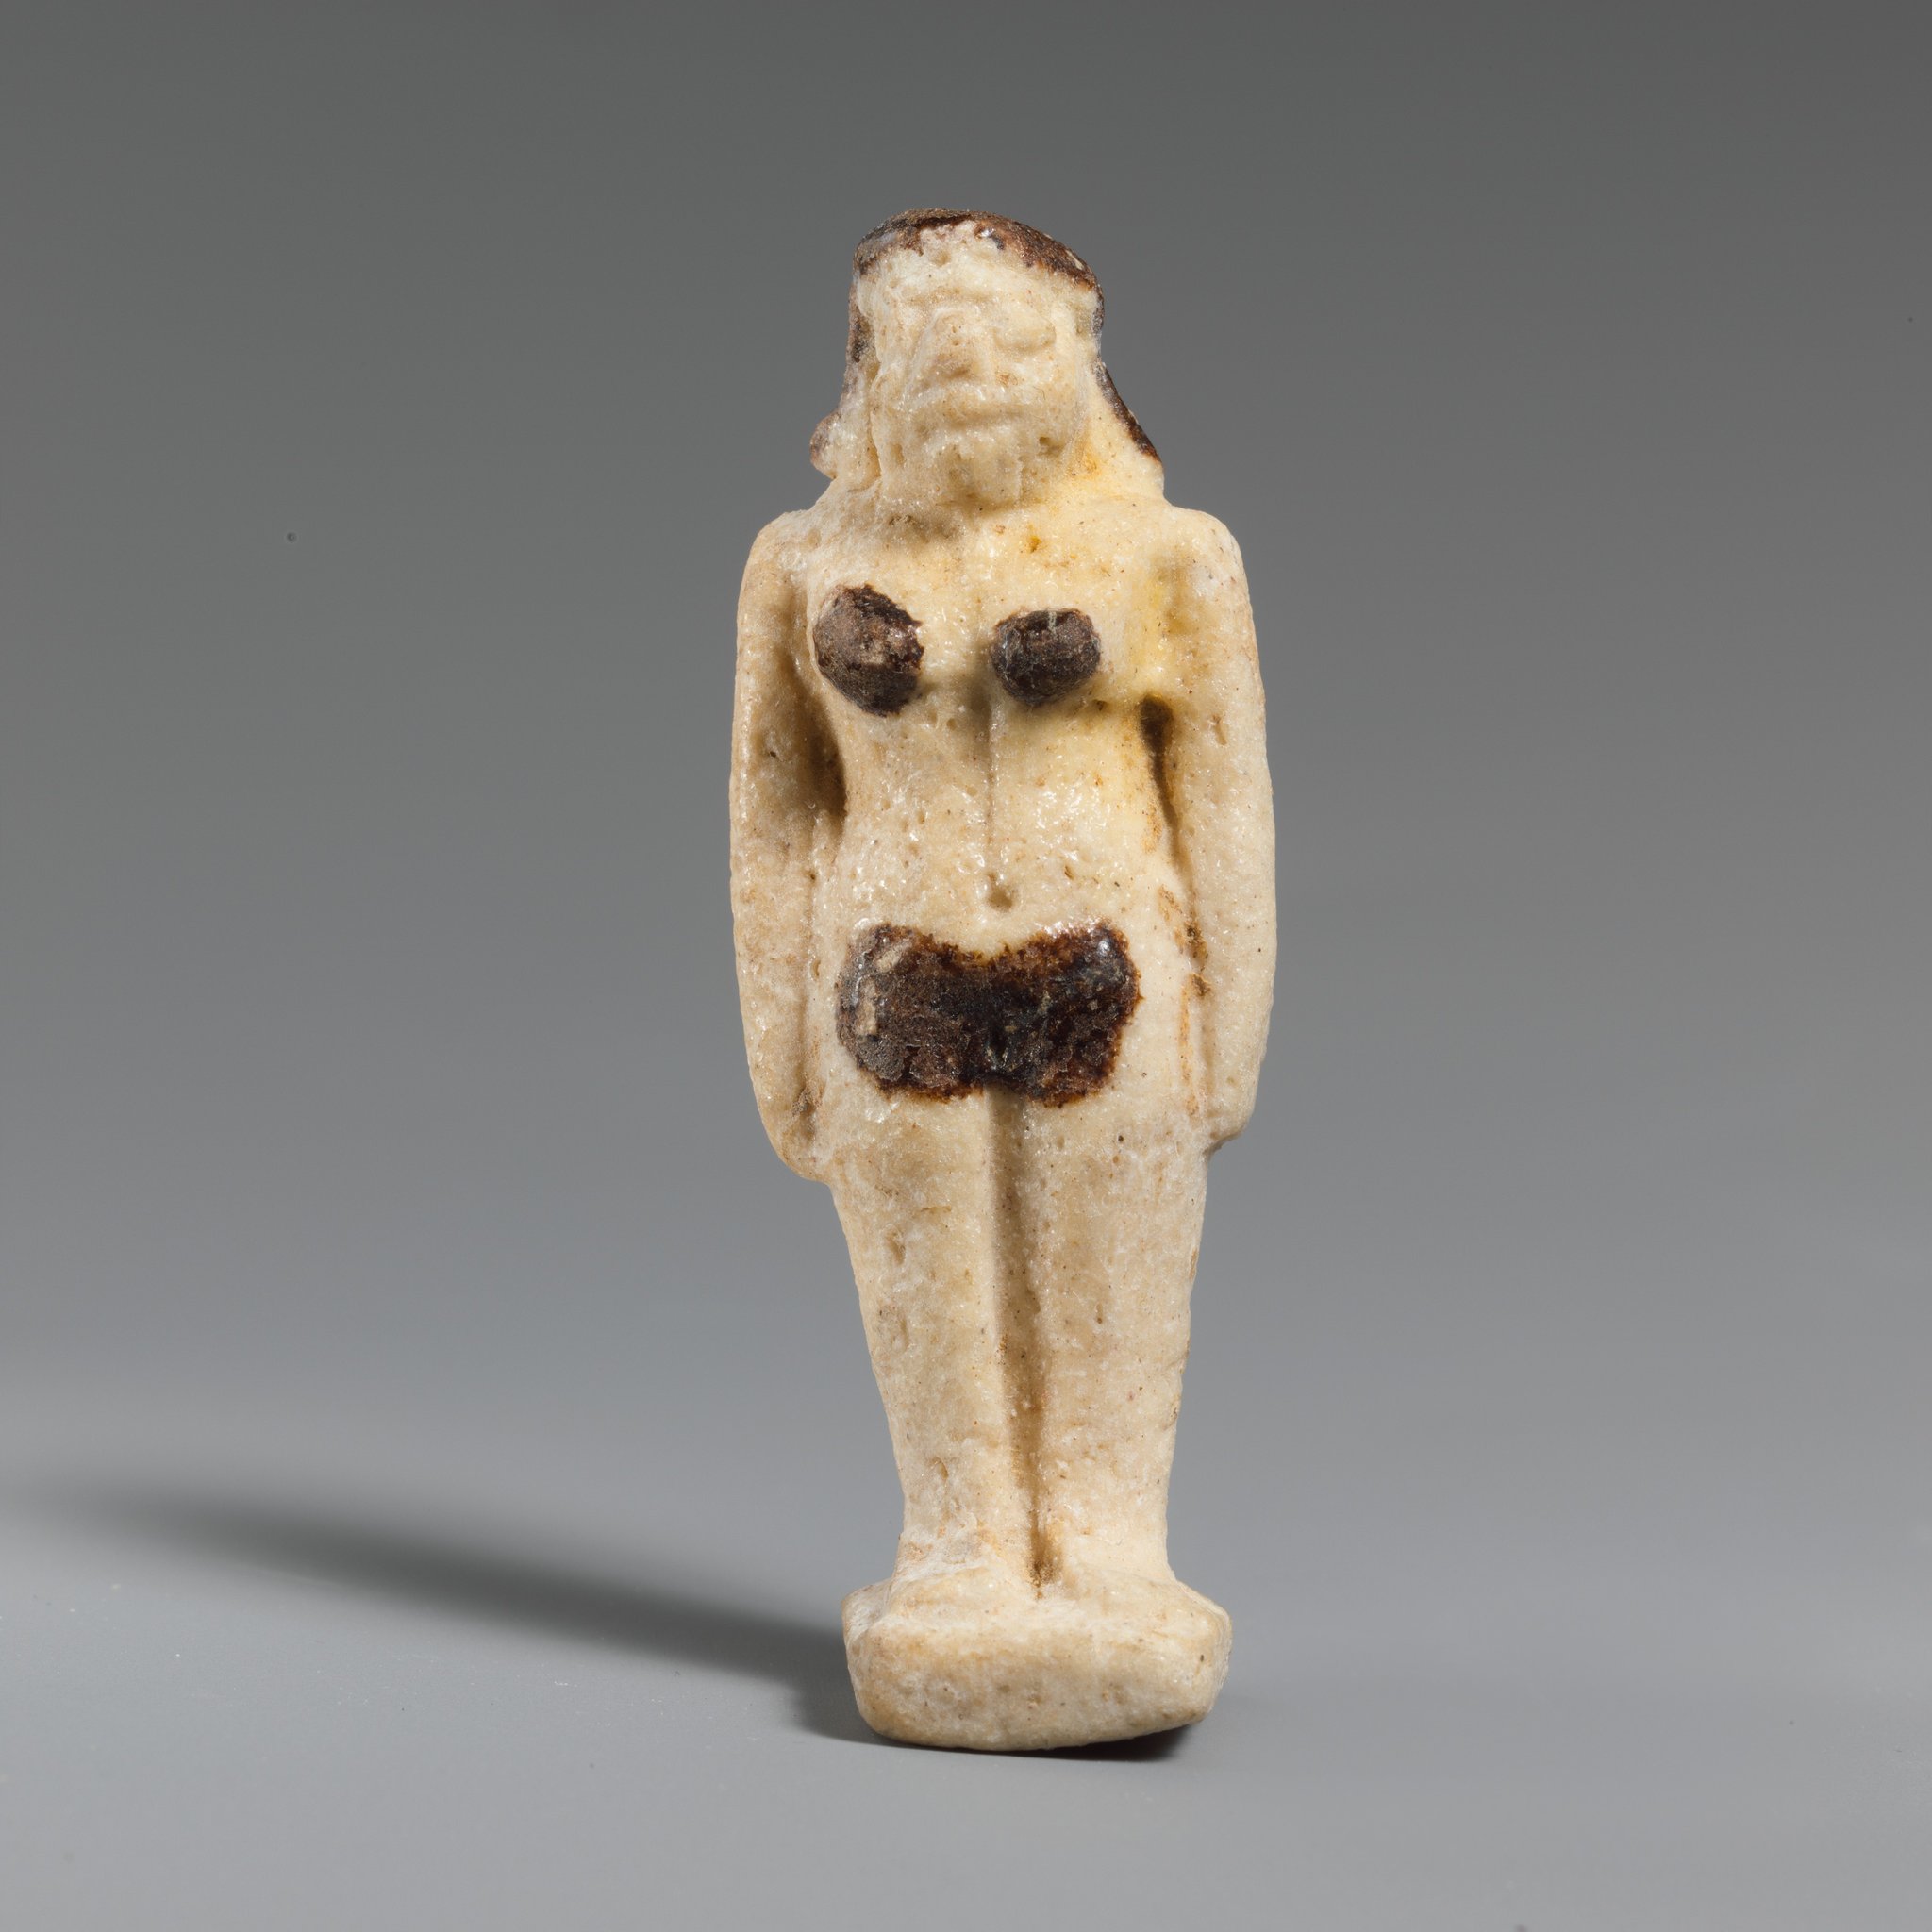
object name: statuette of a woman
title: Faience statuette of a woman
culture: east greek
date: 634-501 BCE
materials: faience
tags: female nudes